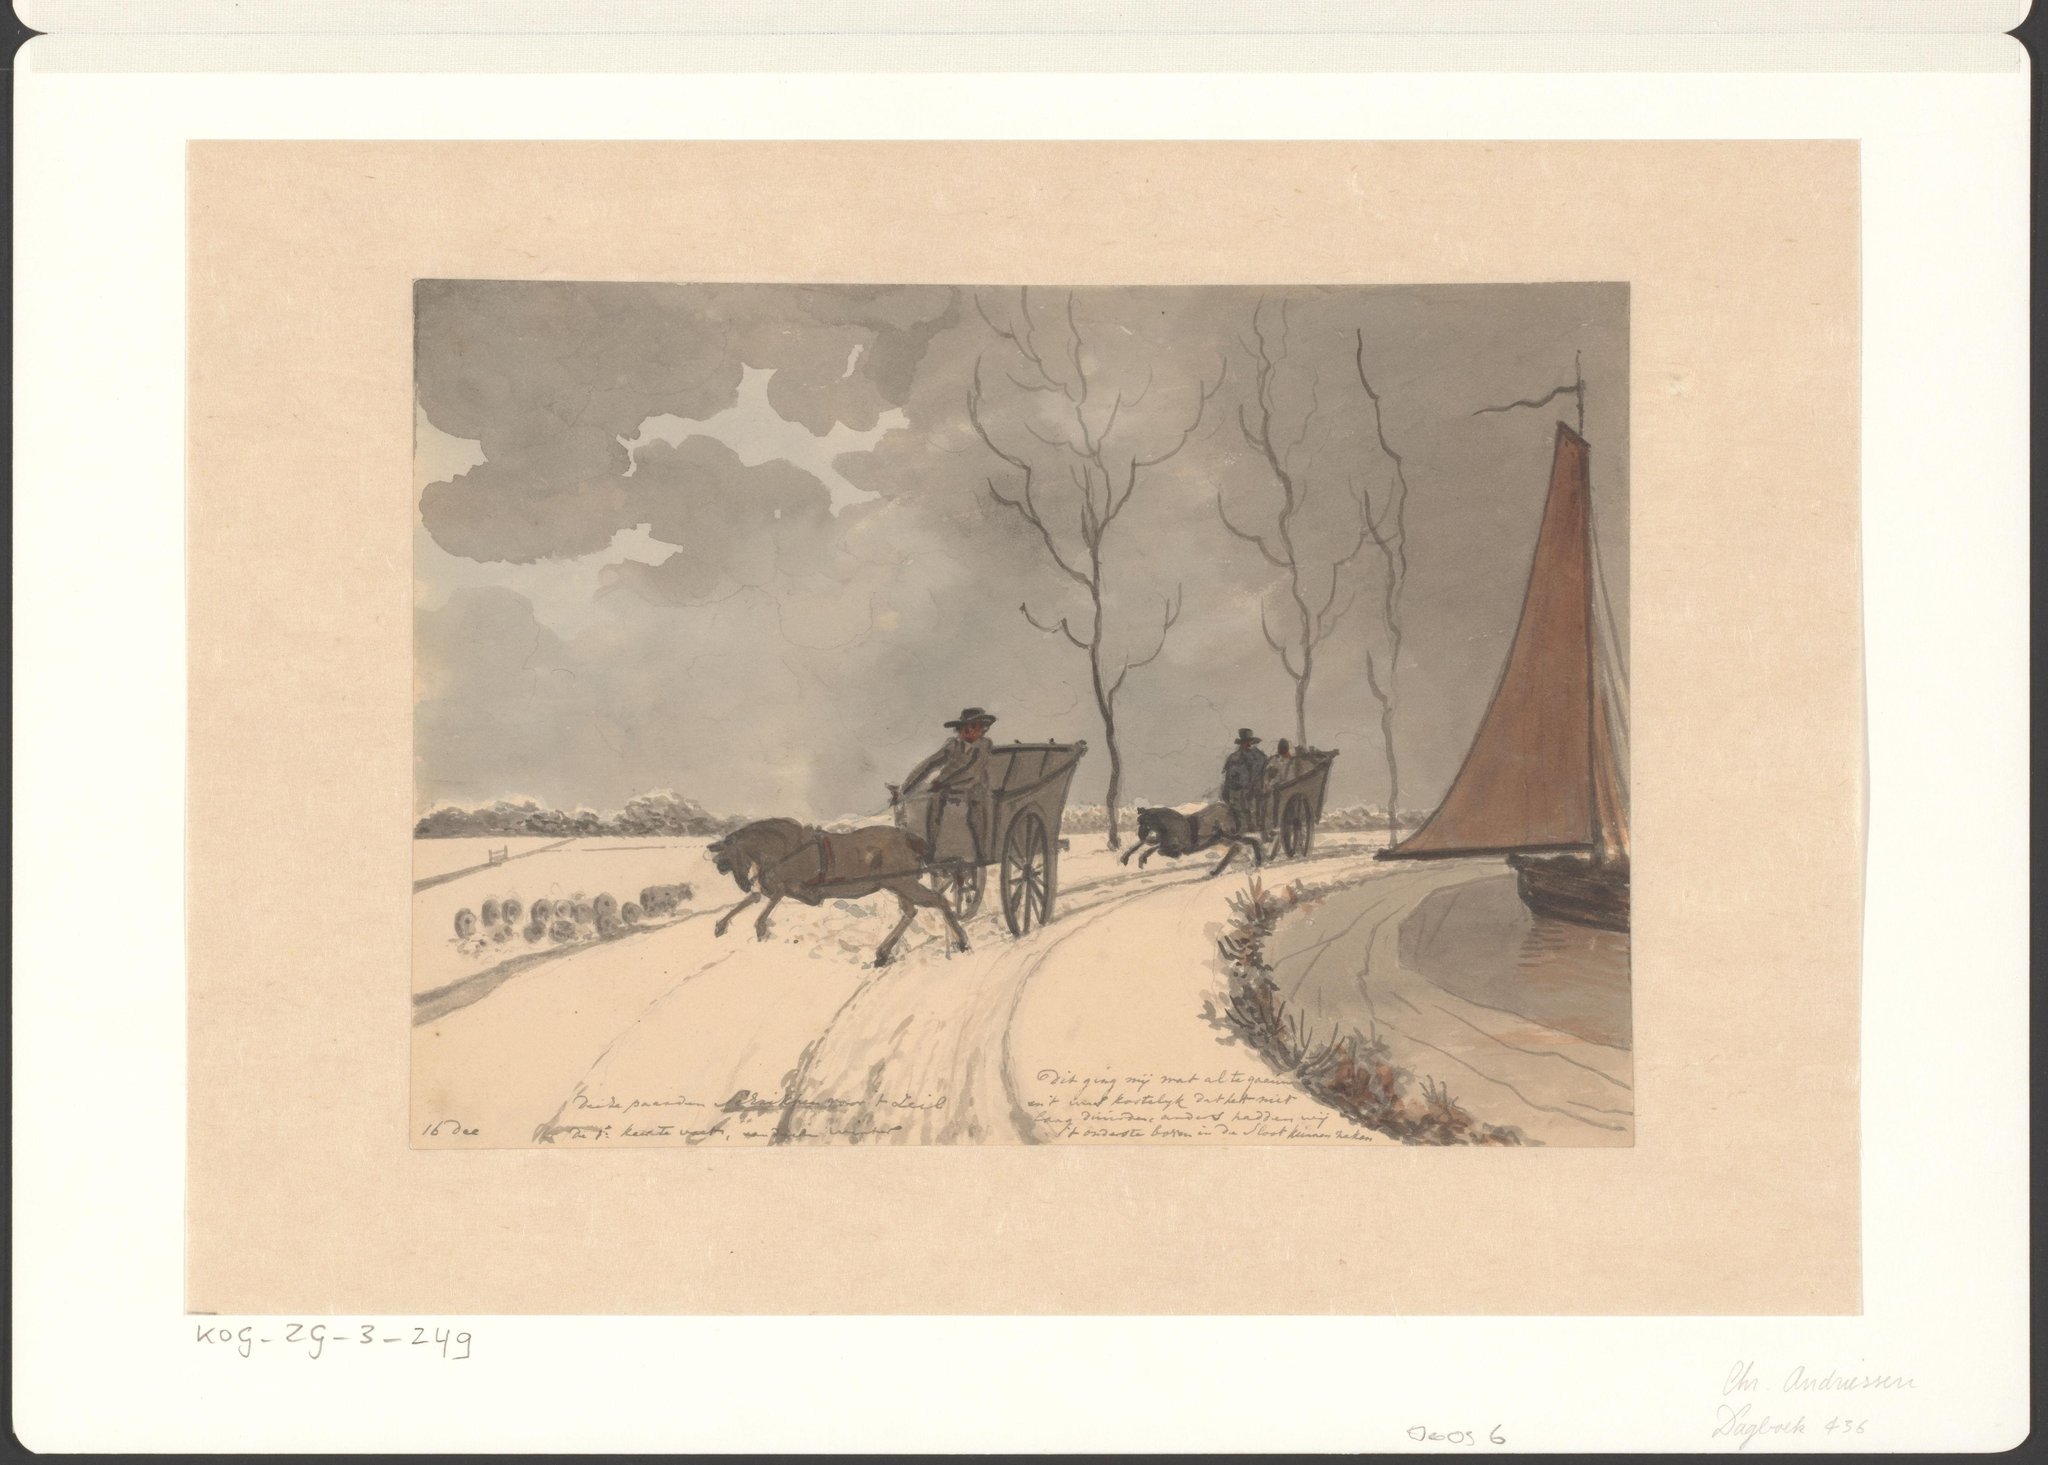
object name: drawing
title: Twee paarden schrikken van een zeilschip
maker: christiaan andriessen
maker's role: draughtsman, print maker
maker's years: 1775-1846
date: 1805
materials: ink, paper, pencil, watercolor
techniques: brush, pen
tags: amsterdam, print maker, draughtsman, christiaan andriessen, sail, animal traction, animal-drawn vehicle (carriage etc.), sailing-ship, sailing-boat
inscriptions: signature: ‘J Andriessen’, inscription: ‘16 dec deeze paarden schrikken van 't zeil’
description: De paarden van twee boerenwagens die op een besneeuwde dijk rijden, schrikken als het zeil van een langsvarende boot plotseling overstag gaat.